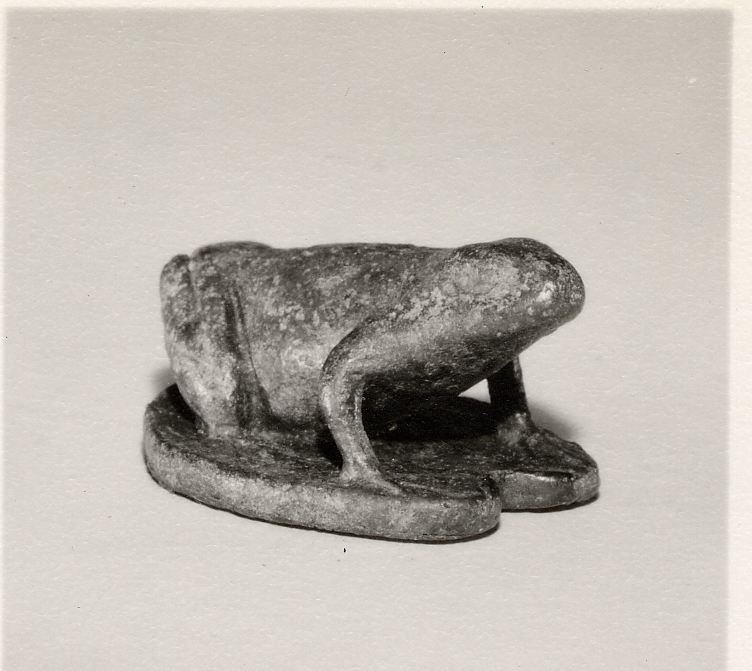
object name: amulet, frog on a lotus pad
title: Frog on a lotus pad, perhaps a weight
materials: bronze, copper alloy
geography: egypt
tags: frogs